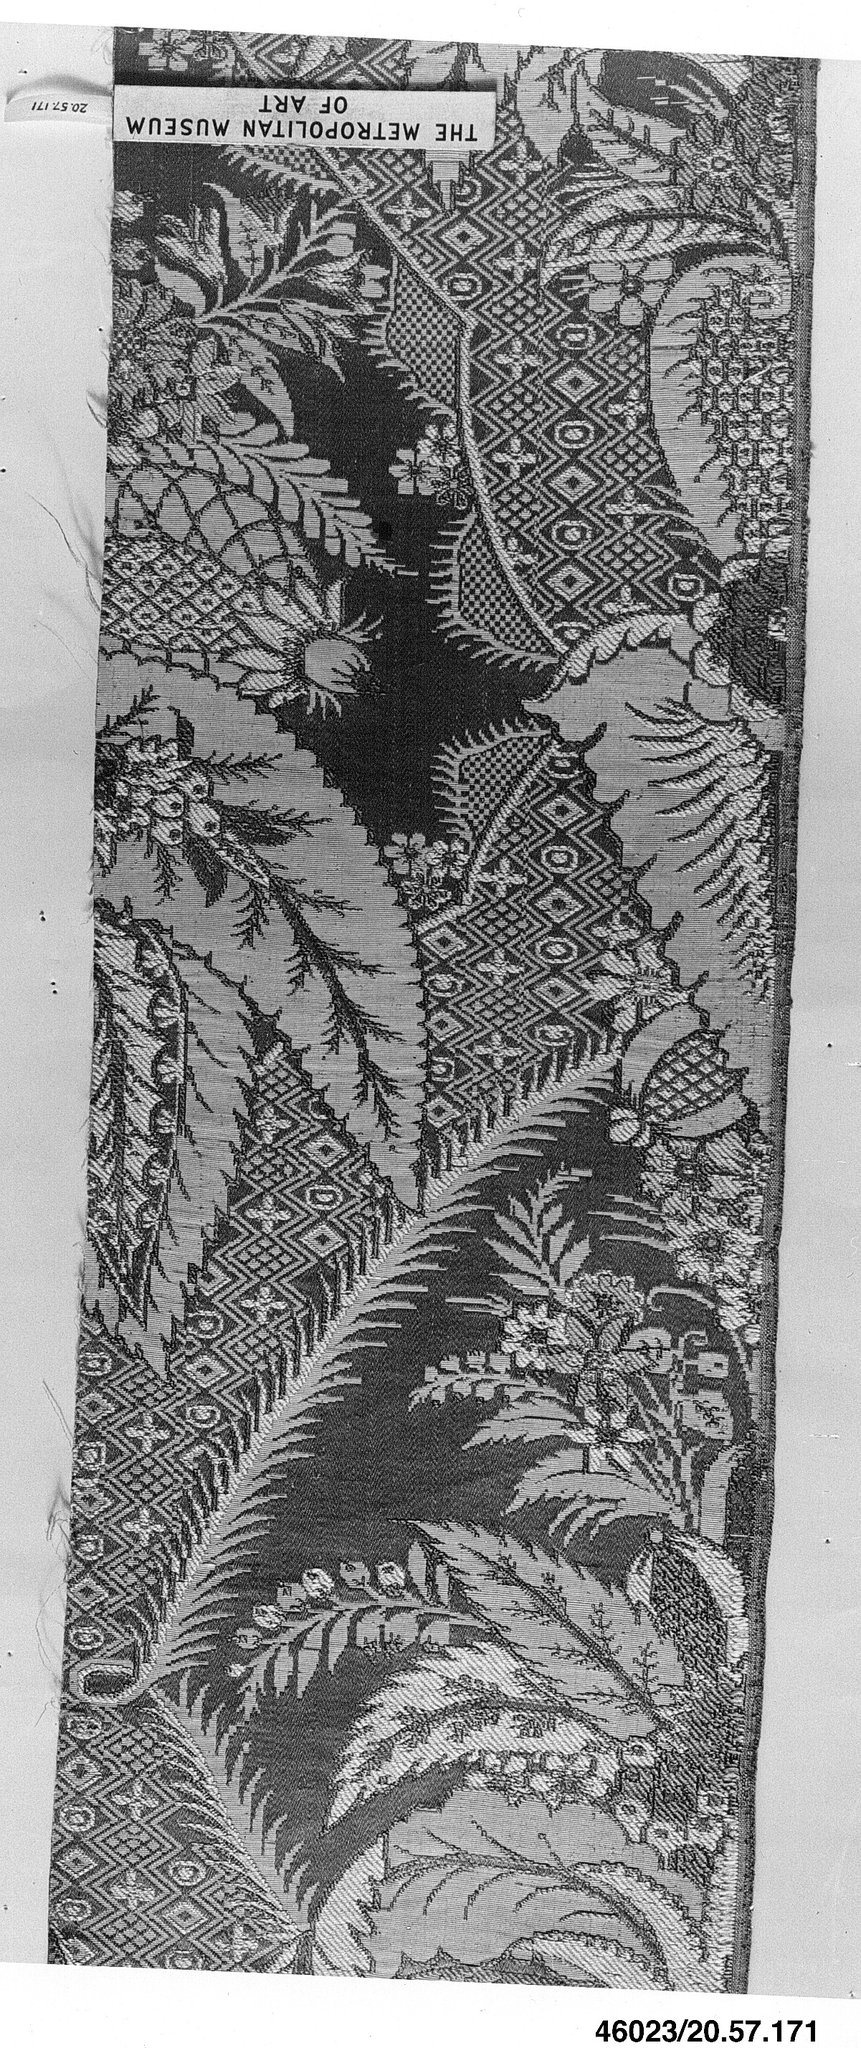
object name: piece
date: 1720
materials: silk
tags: flowers,leaves